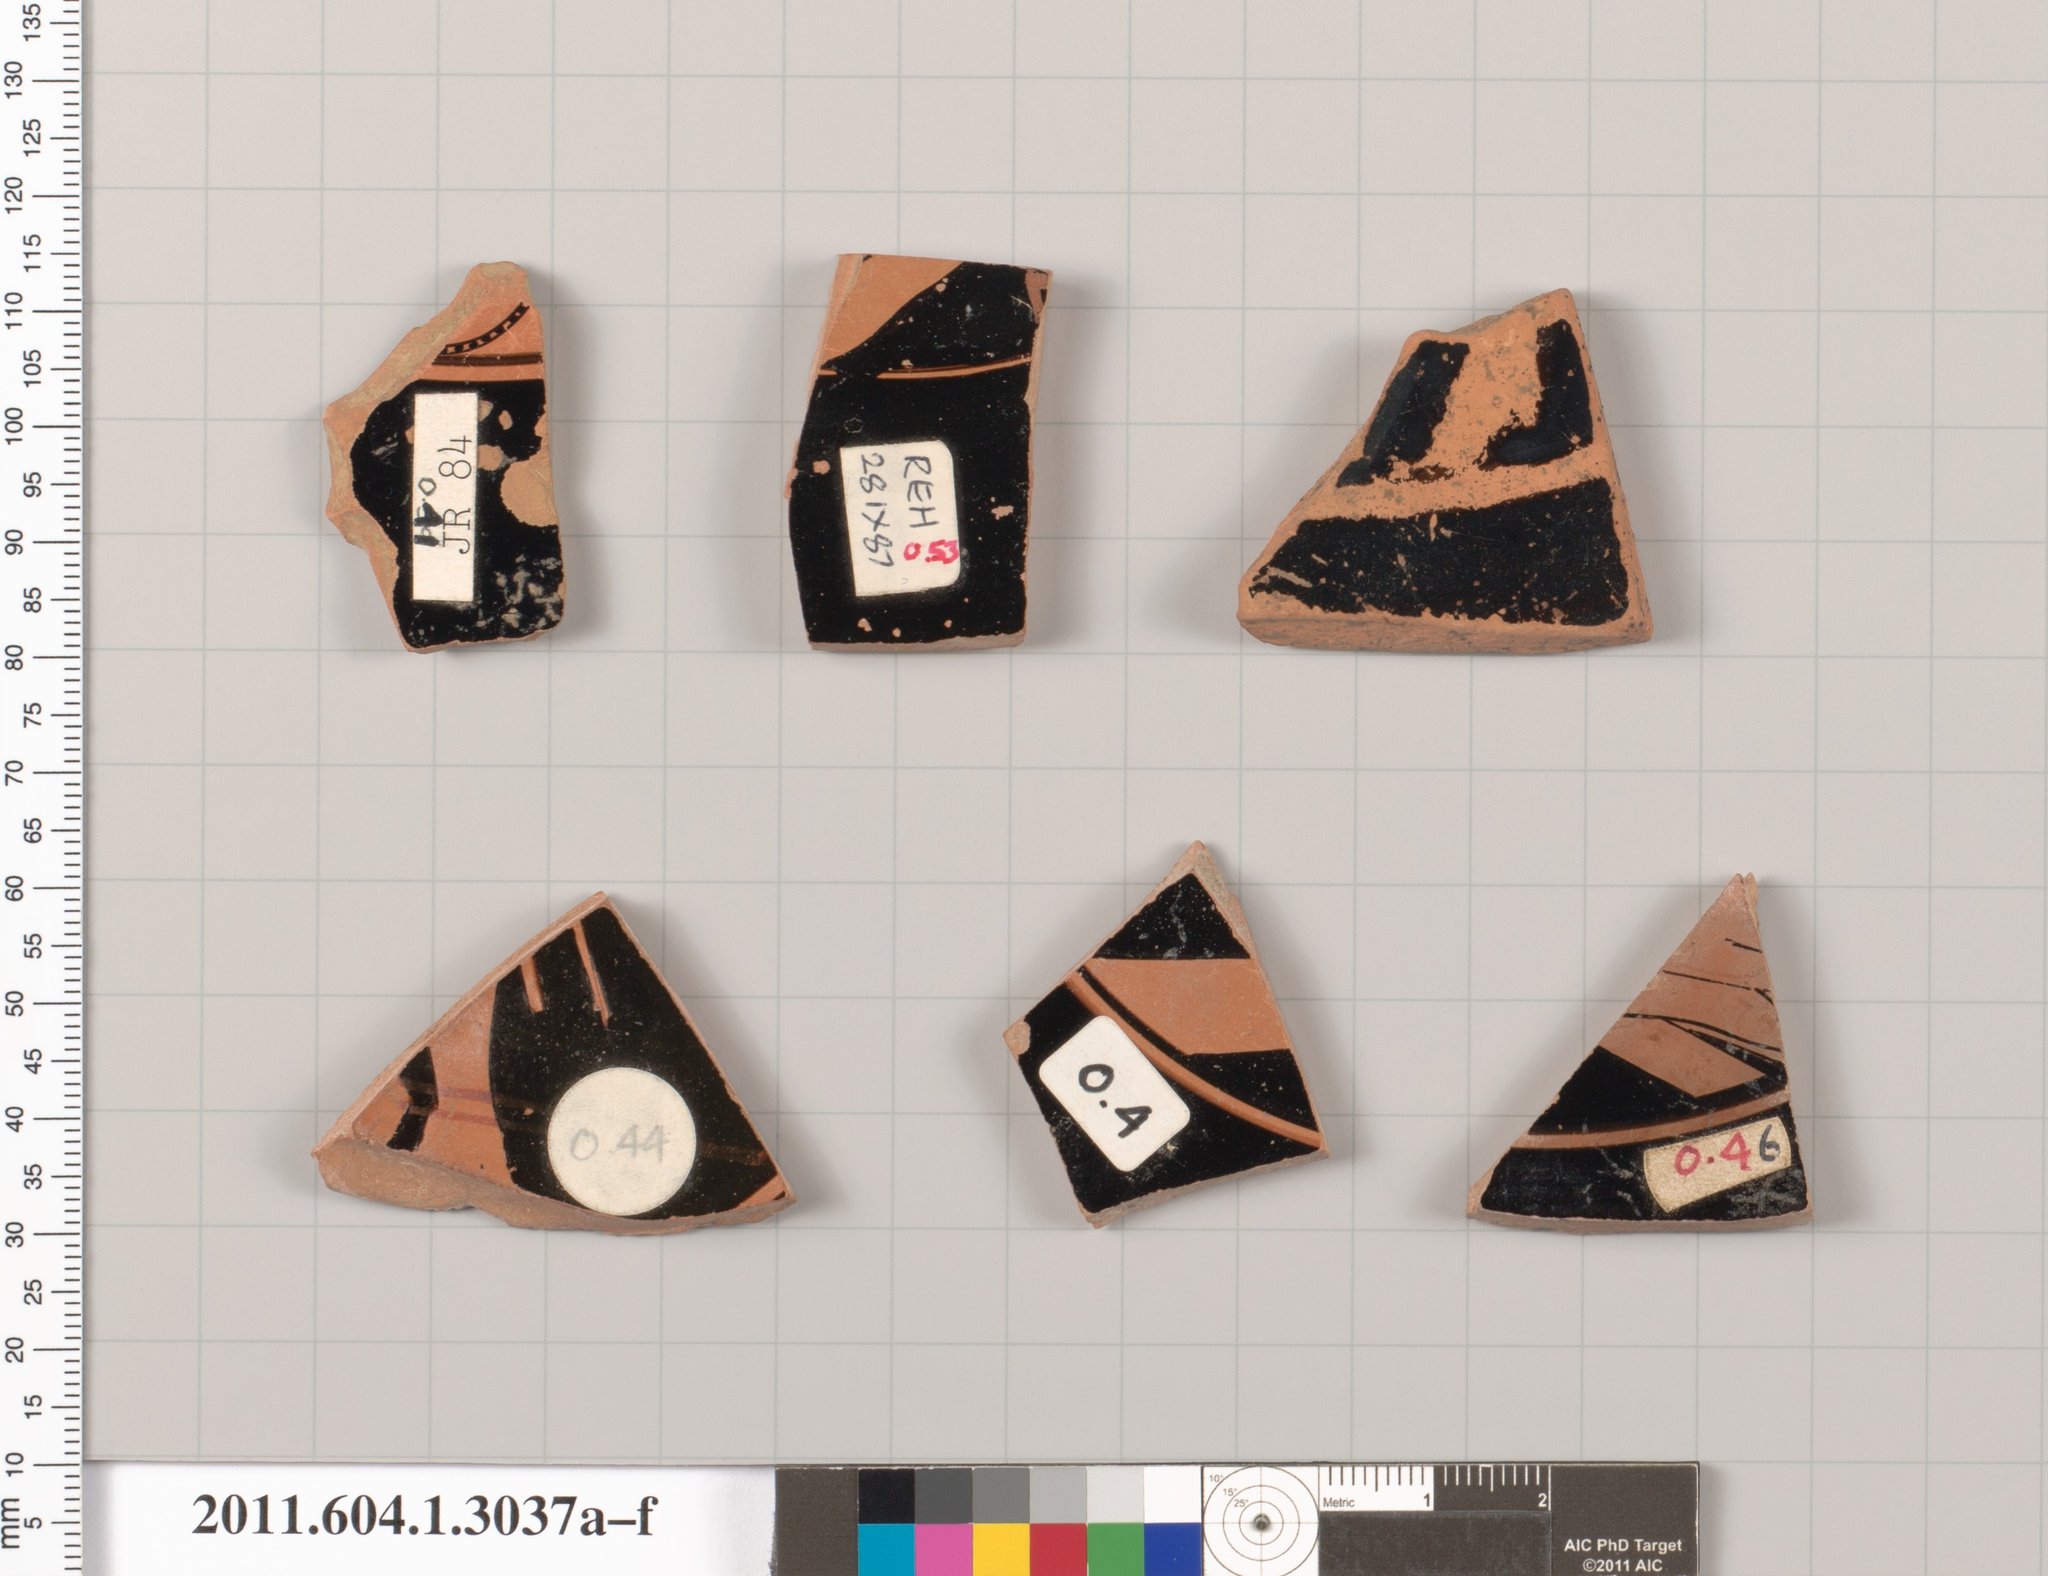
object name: kylix fragment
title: Terracotta fragments of kylikes (drinking cups)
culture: greek, attic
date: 520-480 BCE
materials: terracotta